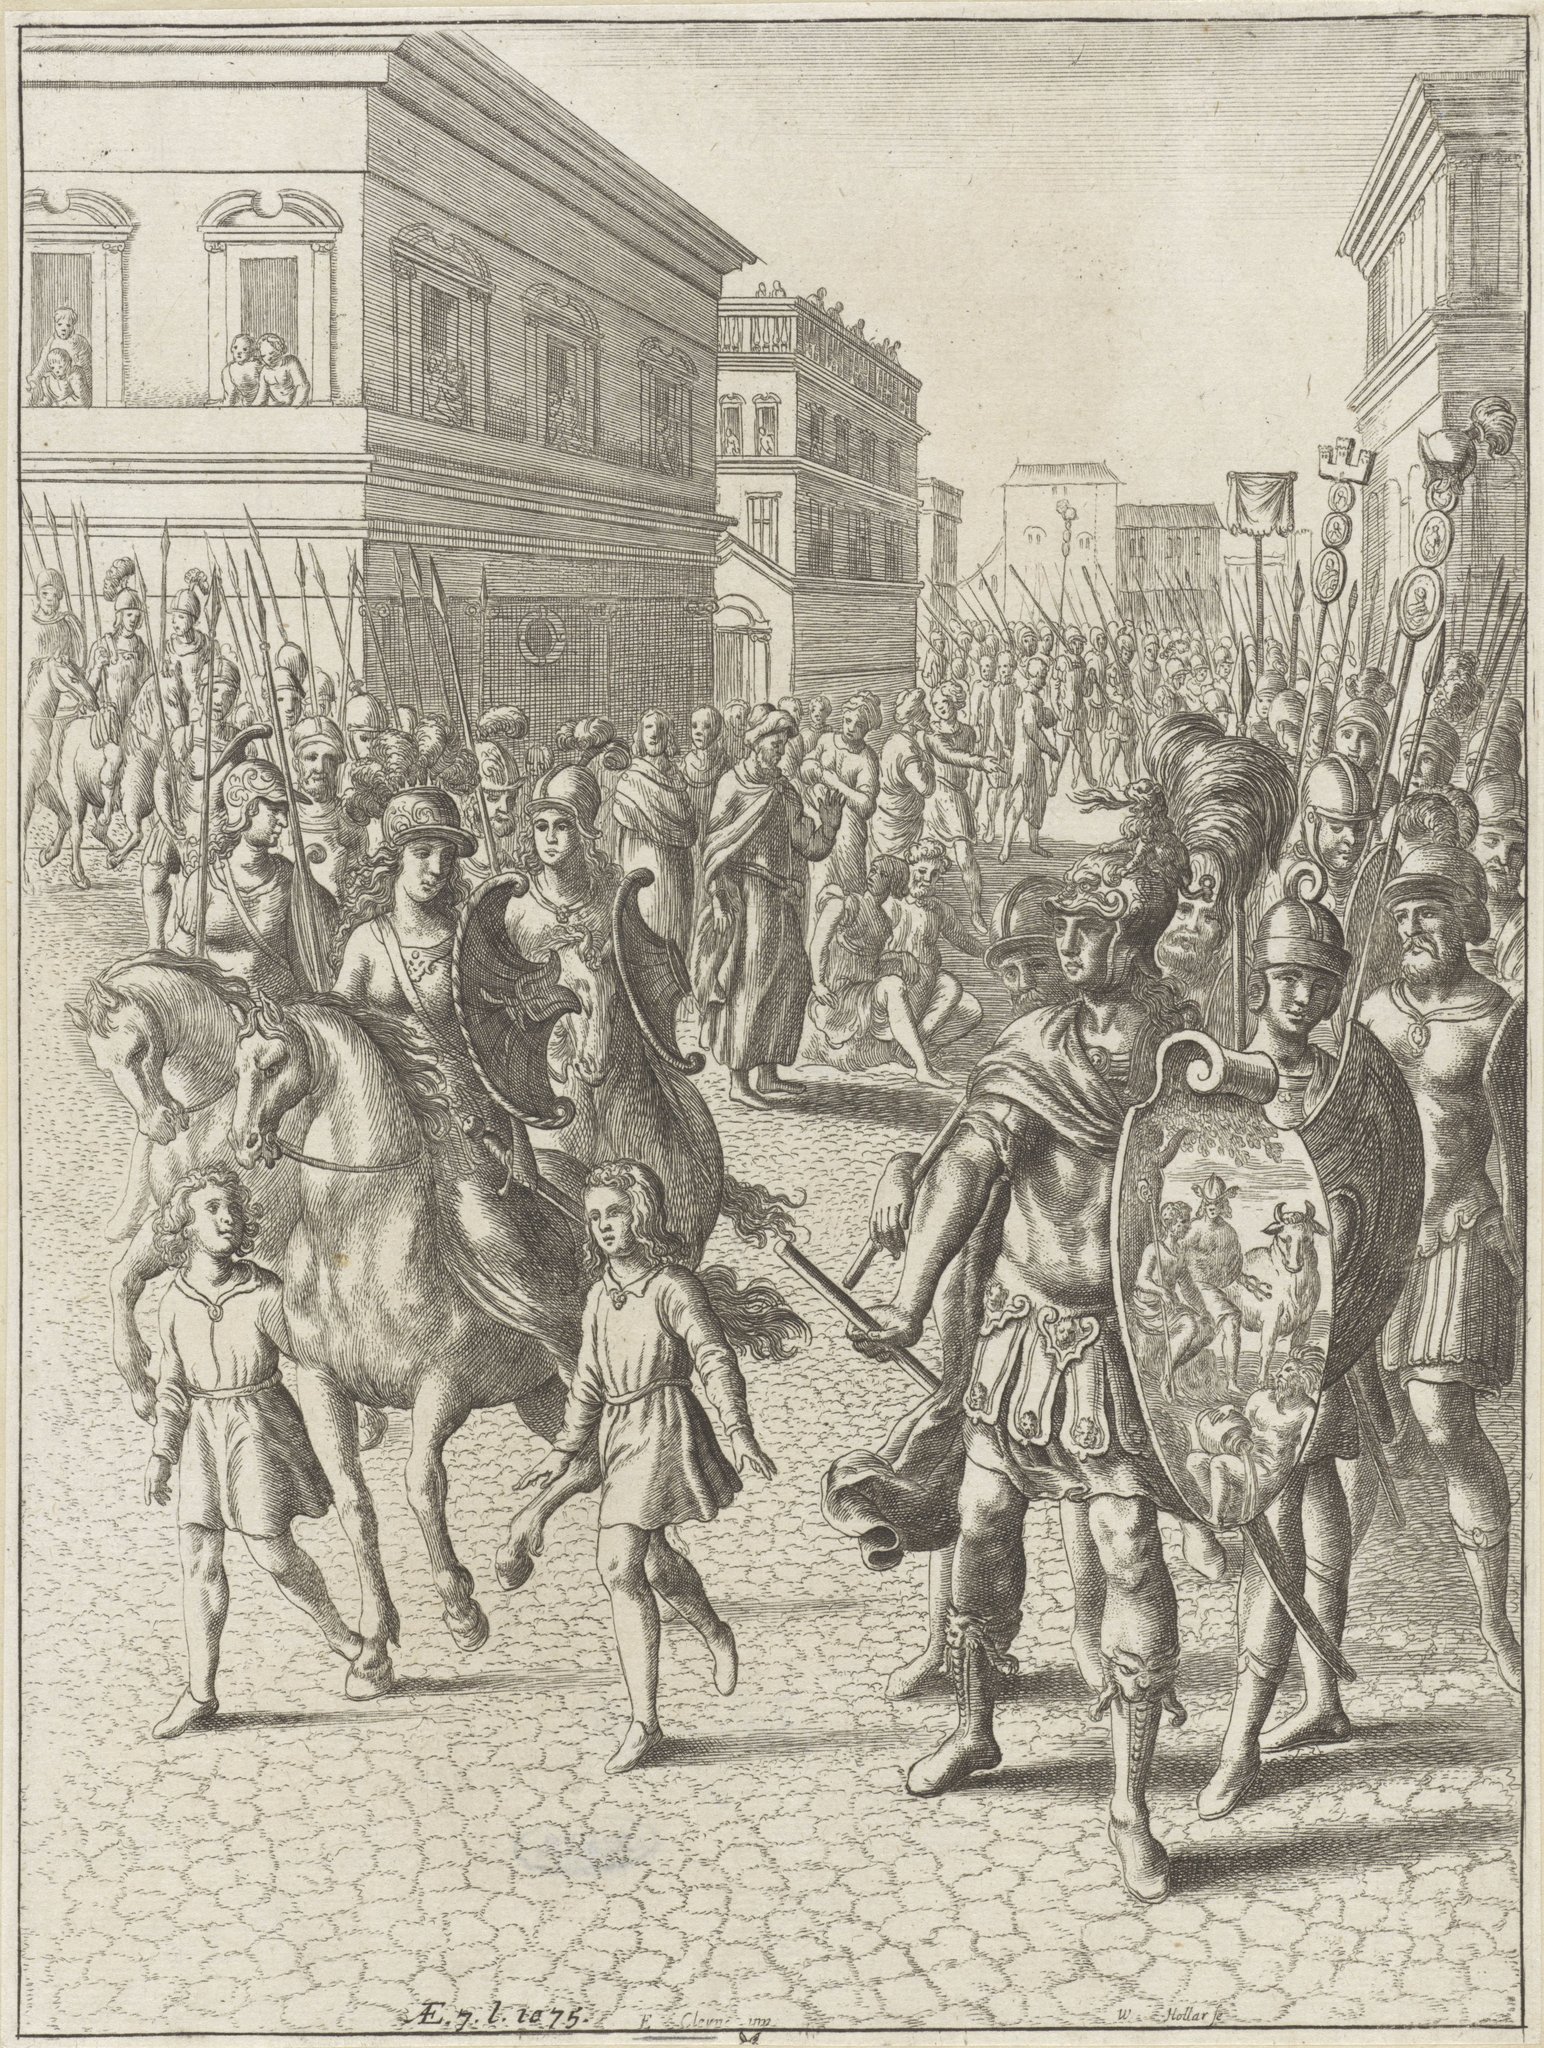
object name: book illustration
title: Werken van Vergilius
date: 1654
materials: paper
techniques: etching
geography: london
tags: (story of) camilla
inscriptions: collector's mark: Lugt 2228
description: Prent opgenomen in: Vergilius Maro, Publius. The works of Publius Virgilius Maro. Translated, adorned with sculpture, and illustrated with annotations, by John Ogilby. Londen: Thomas Warren, 1654. Prent tevens opgenomen in latere, in Engeland verschenen, uitgaven van Vergilius´ werken in 1658, 1663, 1668, 1697 en 1698 (zie NHG).